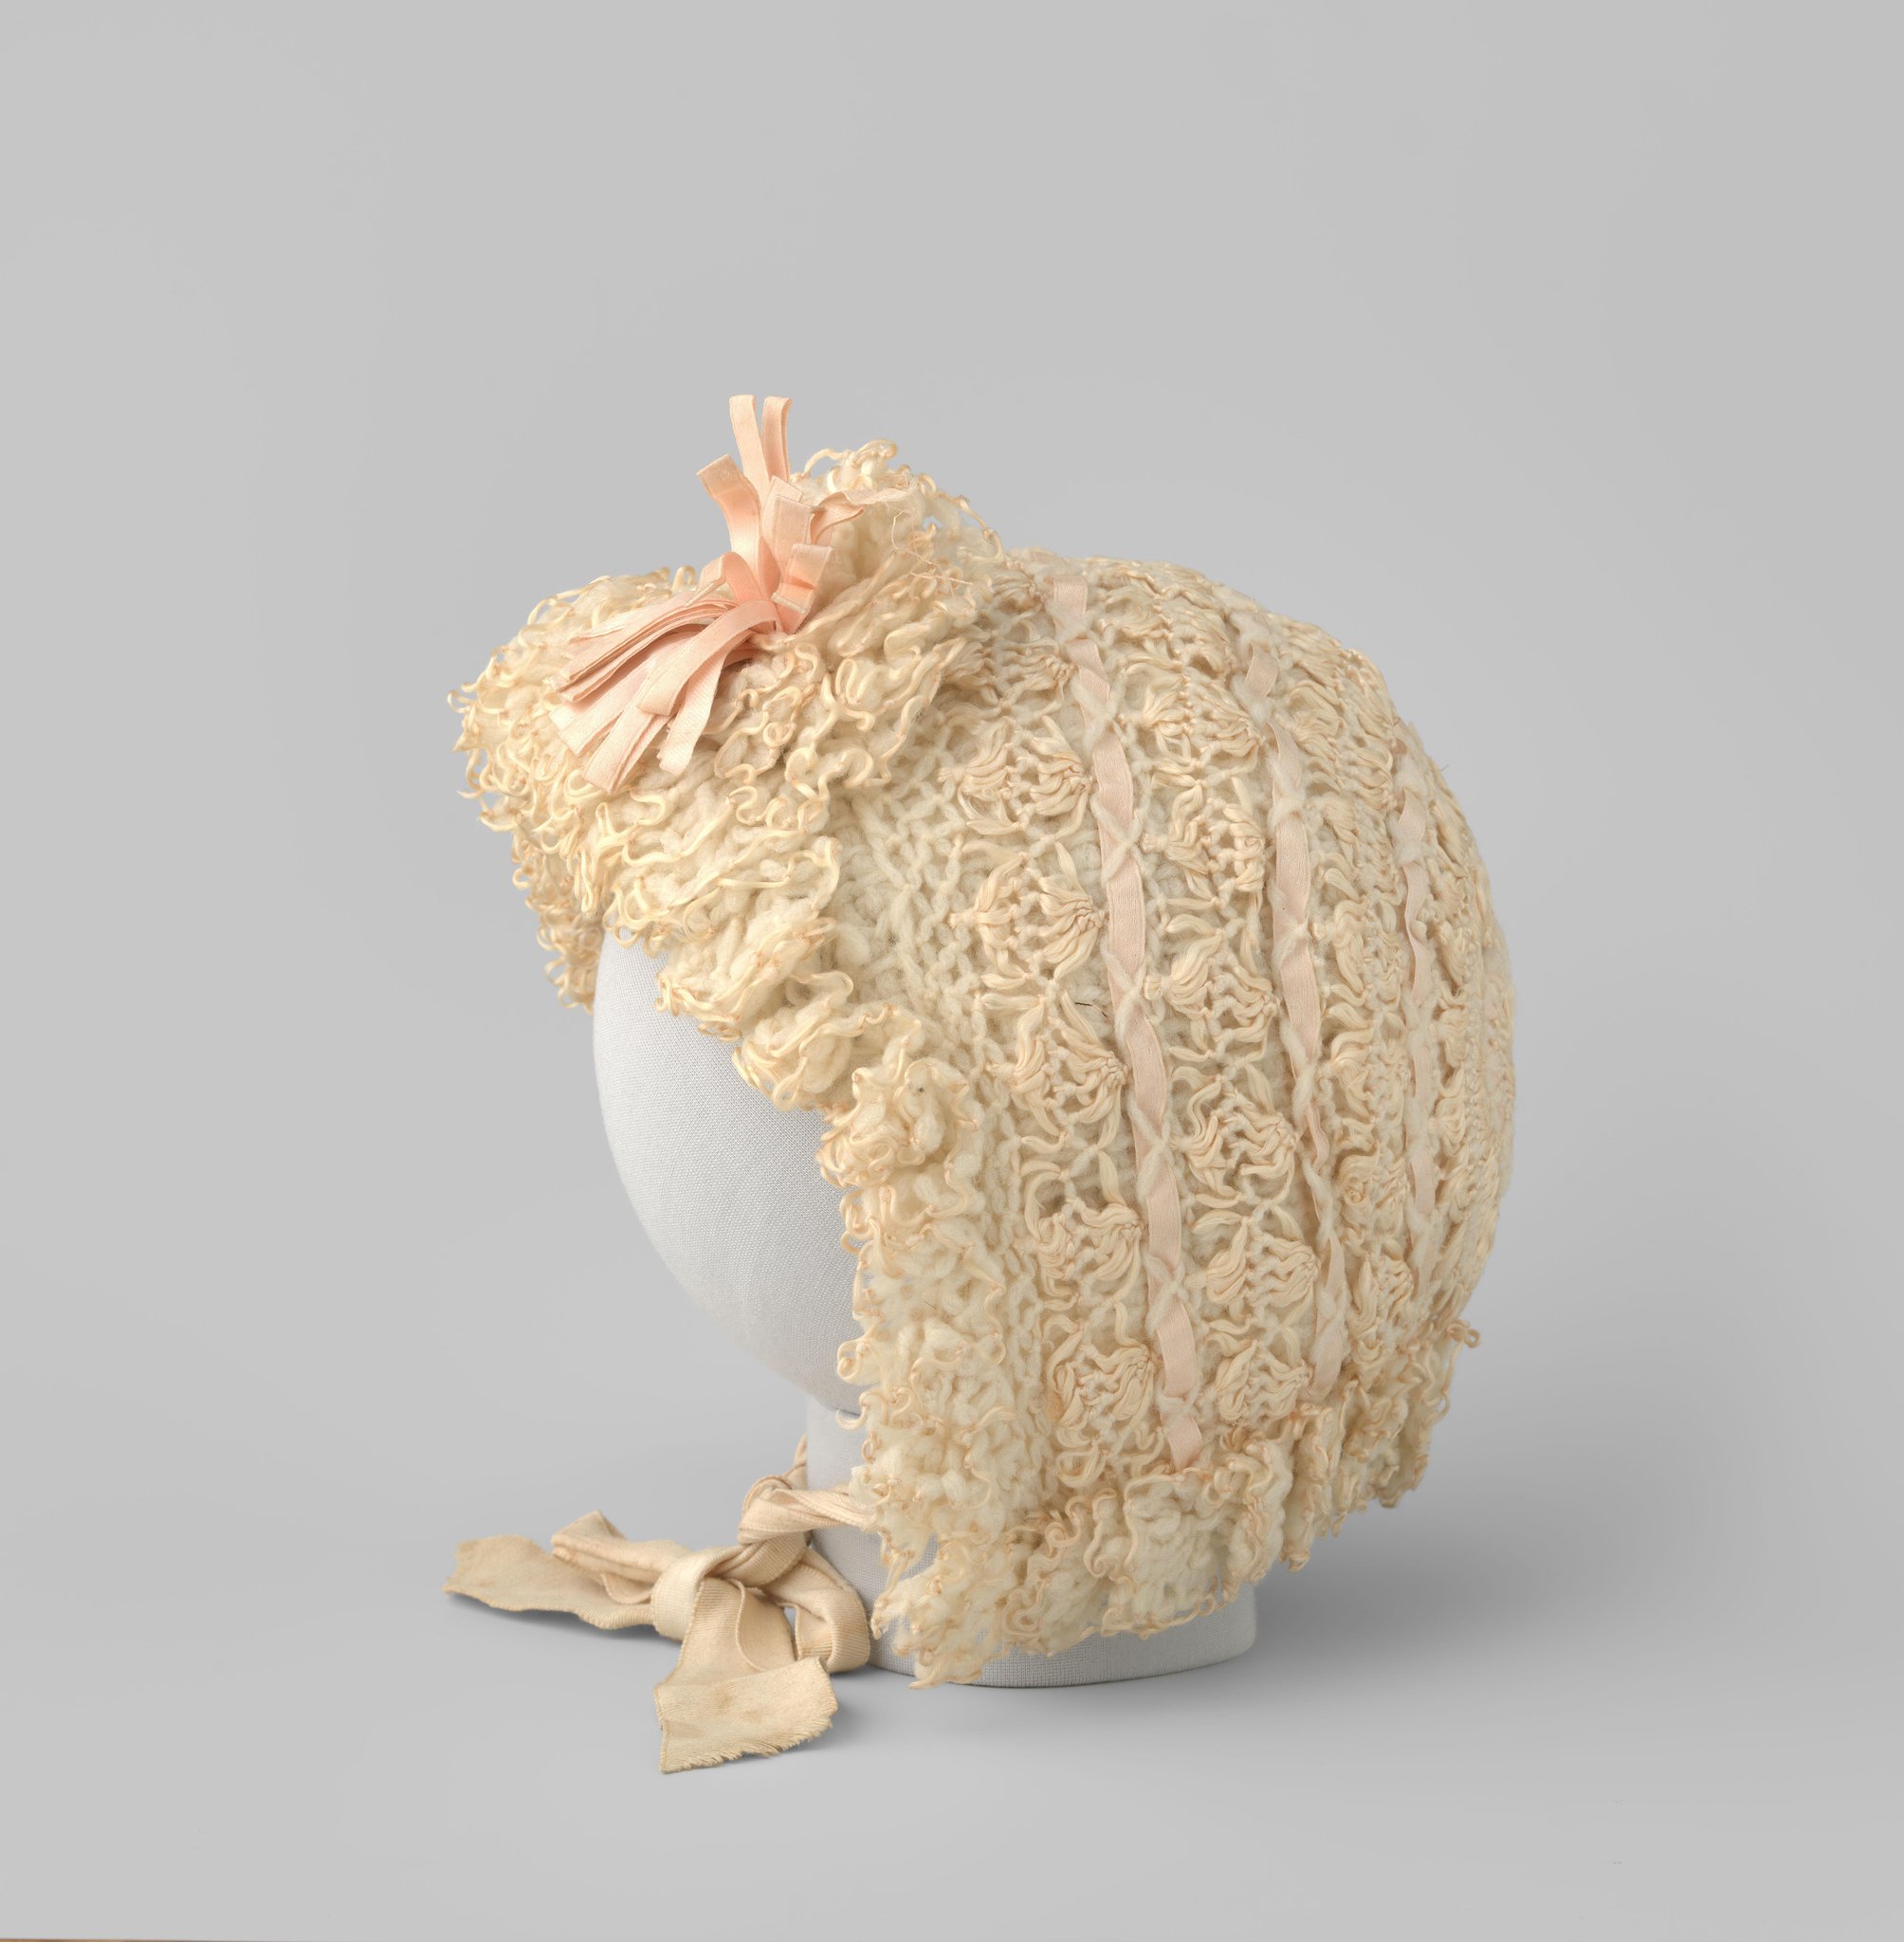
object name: cap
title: Muts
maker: Anonymous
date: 1875-1910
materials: textile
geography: europe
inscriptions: number: ‘85Y’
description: Muts met twee linten aan de uiteinden en twee roze strikken aan de voorzijde. De muts is gevoerd.